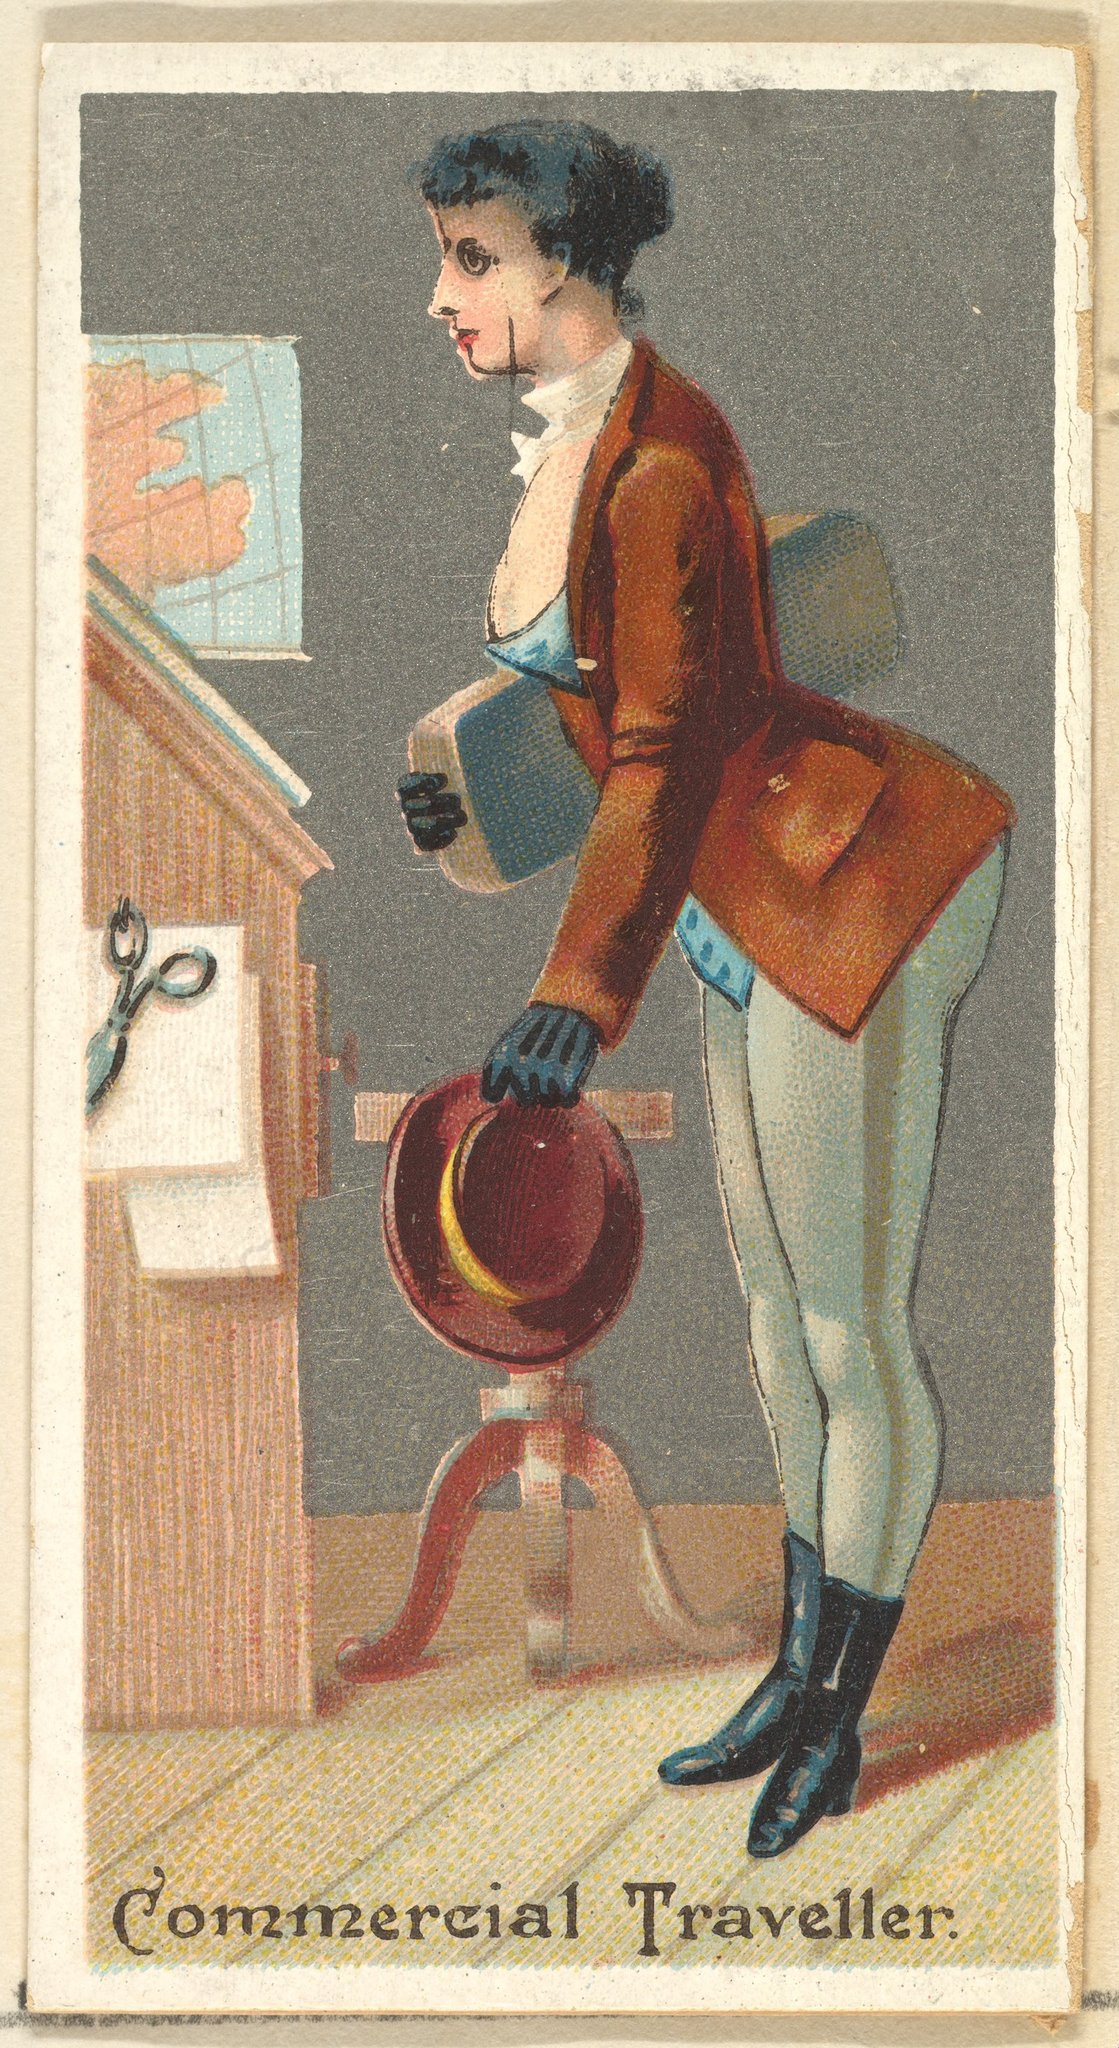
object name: print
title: Commercial Traveller, from the Occupations for Women series (N166) for Old Judge and Dogs Head Cigarettes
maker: goodwin & company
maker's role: publisher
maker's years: 1850-1950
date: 1887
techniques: color lithograph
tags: profiles,women